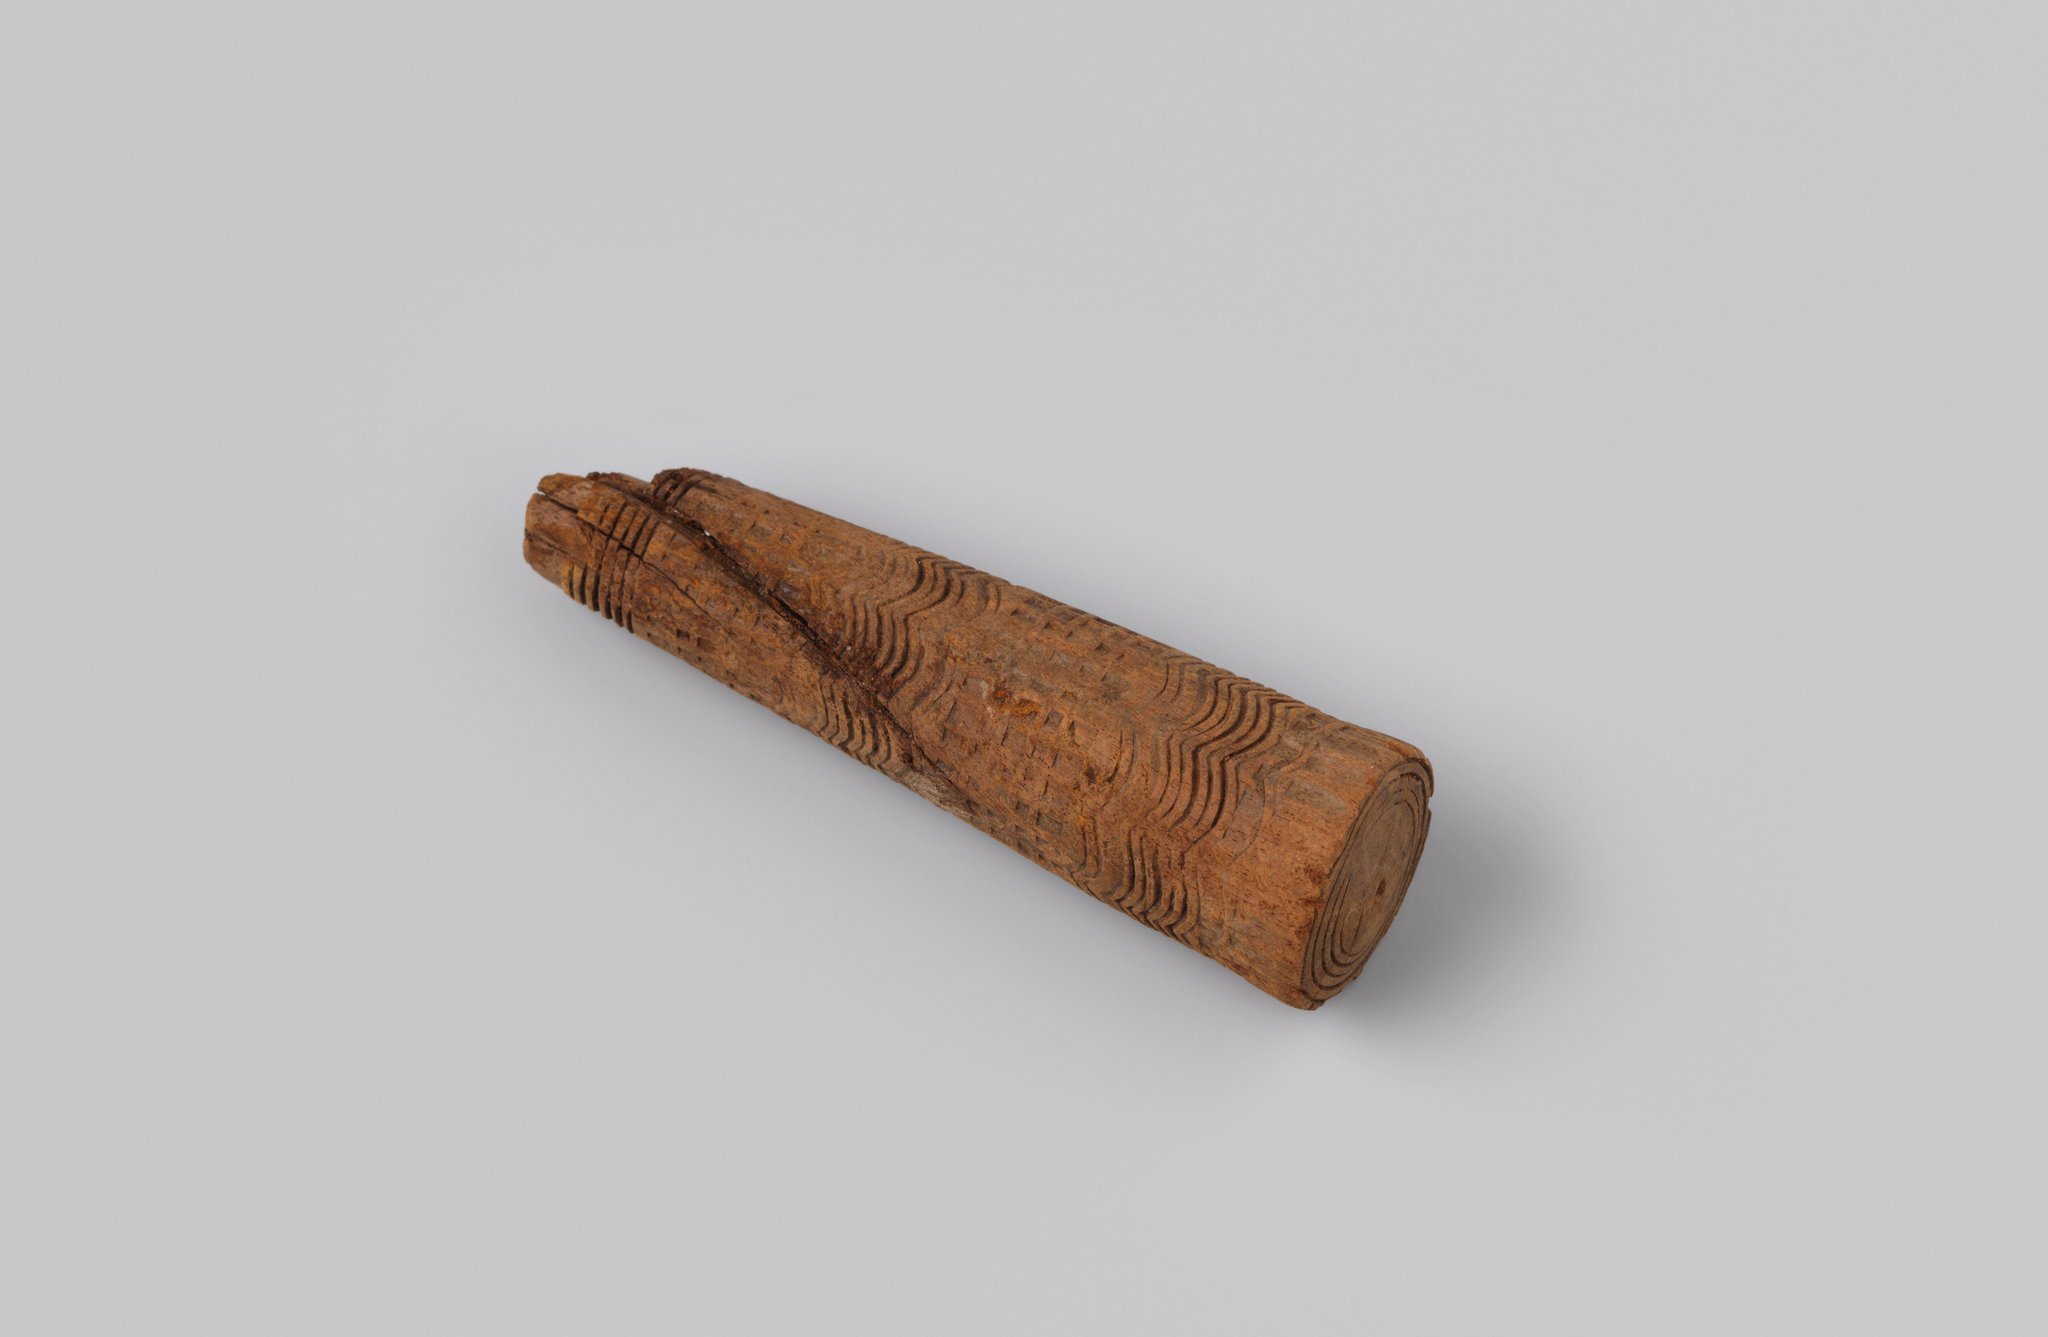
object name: knife handle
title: Messenheft uit het wrak van de Oost-Indiëvaarder Hollandia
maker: Anonymous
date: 1700-1743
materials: wood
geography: netherlands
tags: verenigde oostindische compagnie, hollandia (schip), annet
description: Knife, handle, cylindrical: tapering; id. NG 1979-403H, ferrules id. NG 1980-27H426.